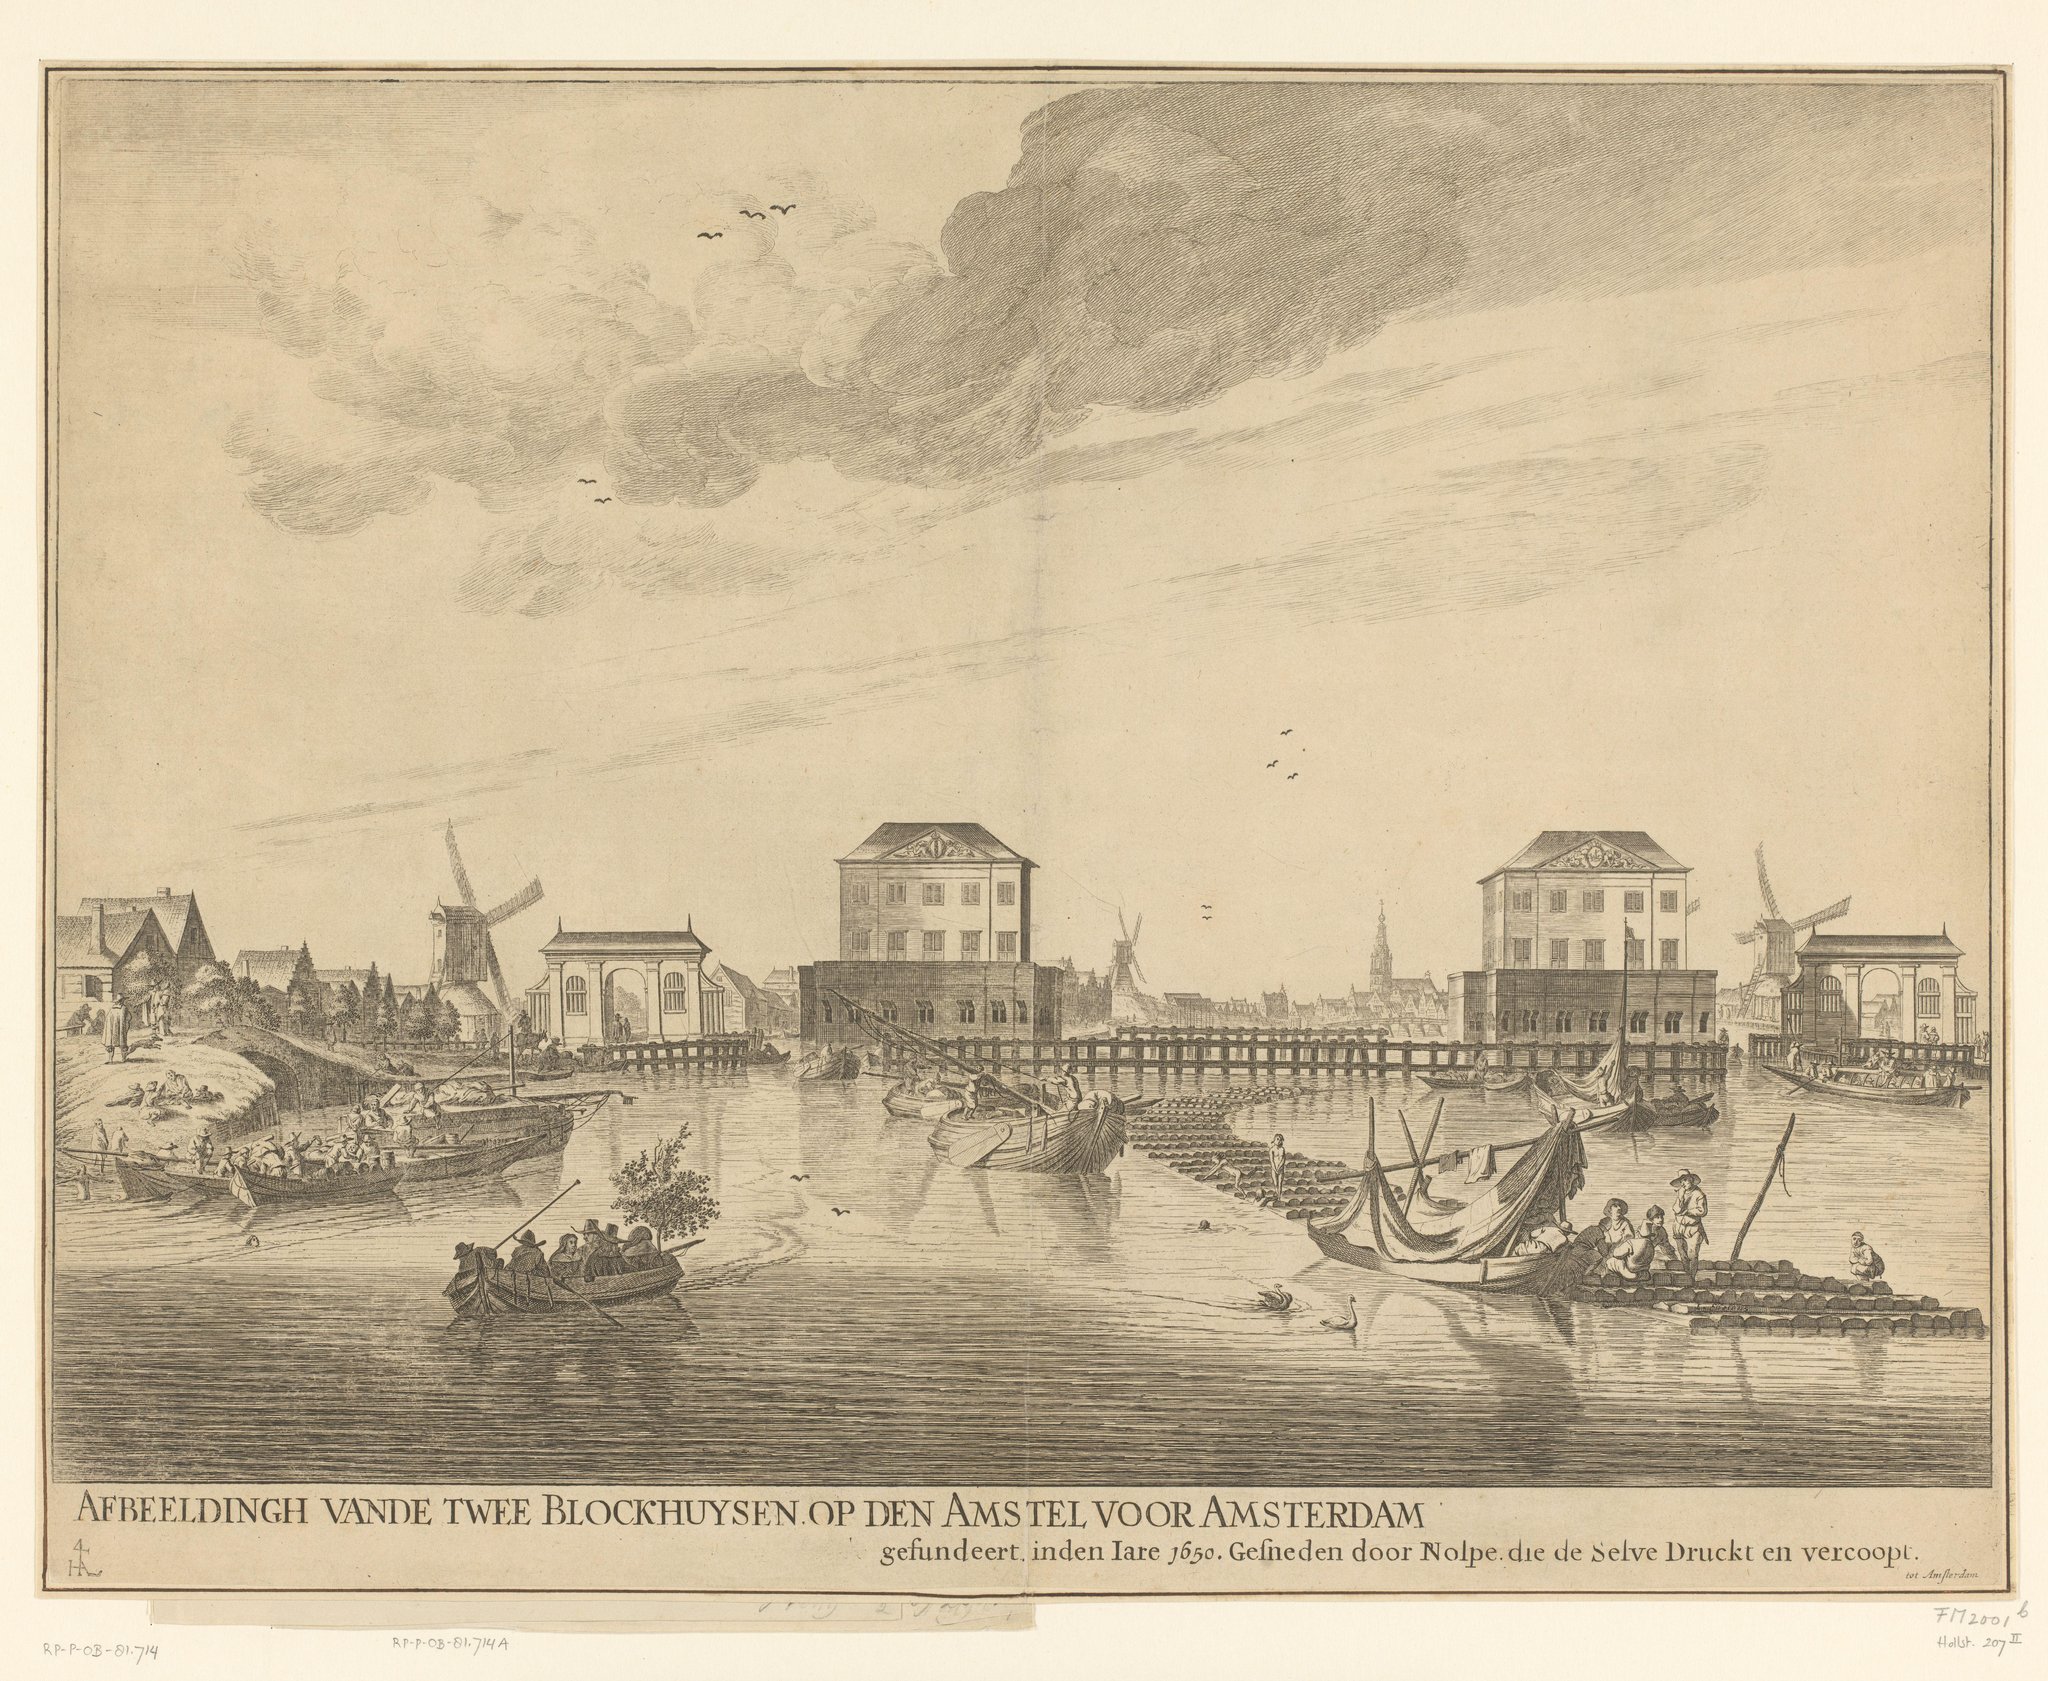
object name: print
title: Afbeeldingh vande twee Blockhuysen, op den Amstel voor Amsterdam gefundeert, inden Jare 1650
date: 1651-1654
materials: paper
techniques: engraving, etching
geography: amsterdam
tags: fortress, church (exterior), swimming (movement in water), windmill, defecation, prospect of city, town panorama, silhouette of city, canal (+ landscape with figures, staffage), amsterdam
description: Gezicht op de twee Blokhuizen in de Amstel buiten Amsterdam, gebouwd ter verdediging van de stad na de mislukte aanslag door Willem II op Amsterdam op 30 juli 1650. Nadat ze in 1651 waren voltooid werden ze in juli 1654 alweer afgebroken. Links en rechts van de Blokhuizen twee hameien. Op het water varen verschillende boten. In een van de boten staat een boompje en op een andere wordt de mast gestreken. Vanaf een vlot of steiger zwemmen kinderen en doet rechtsvoor een figuur zijn behoefte. Tussen de twee Blokhuizen op de achtergrond de contouren van de stad met de molen De Joffer en de Zuiderkerk. Links onderaan het getekende monogram van Hugo Allard.